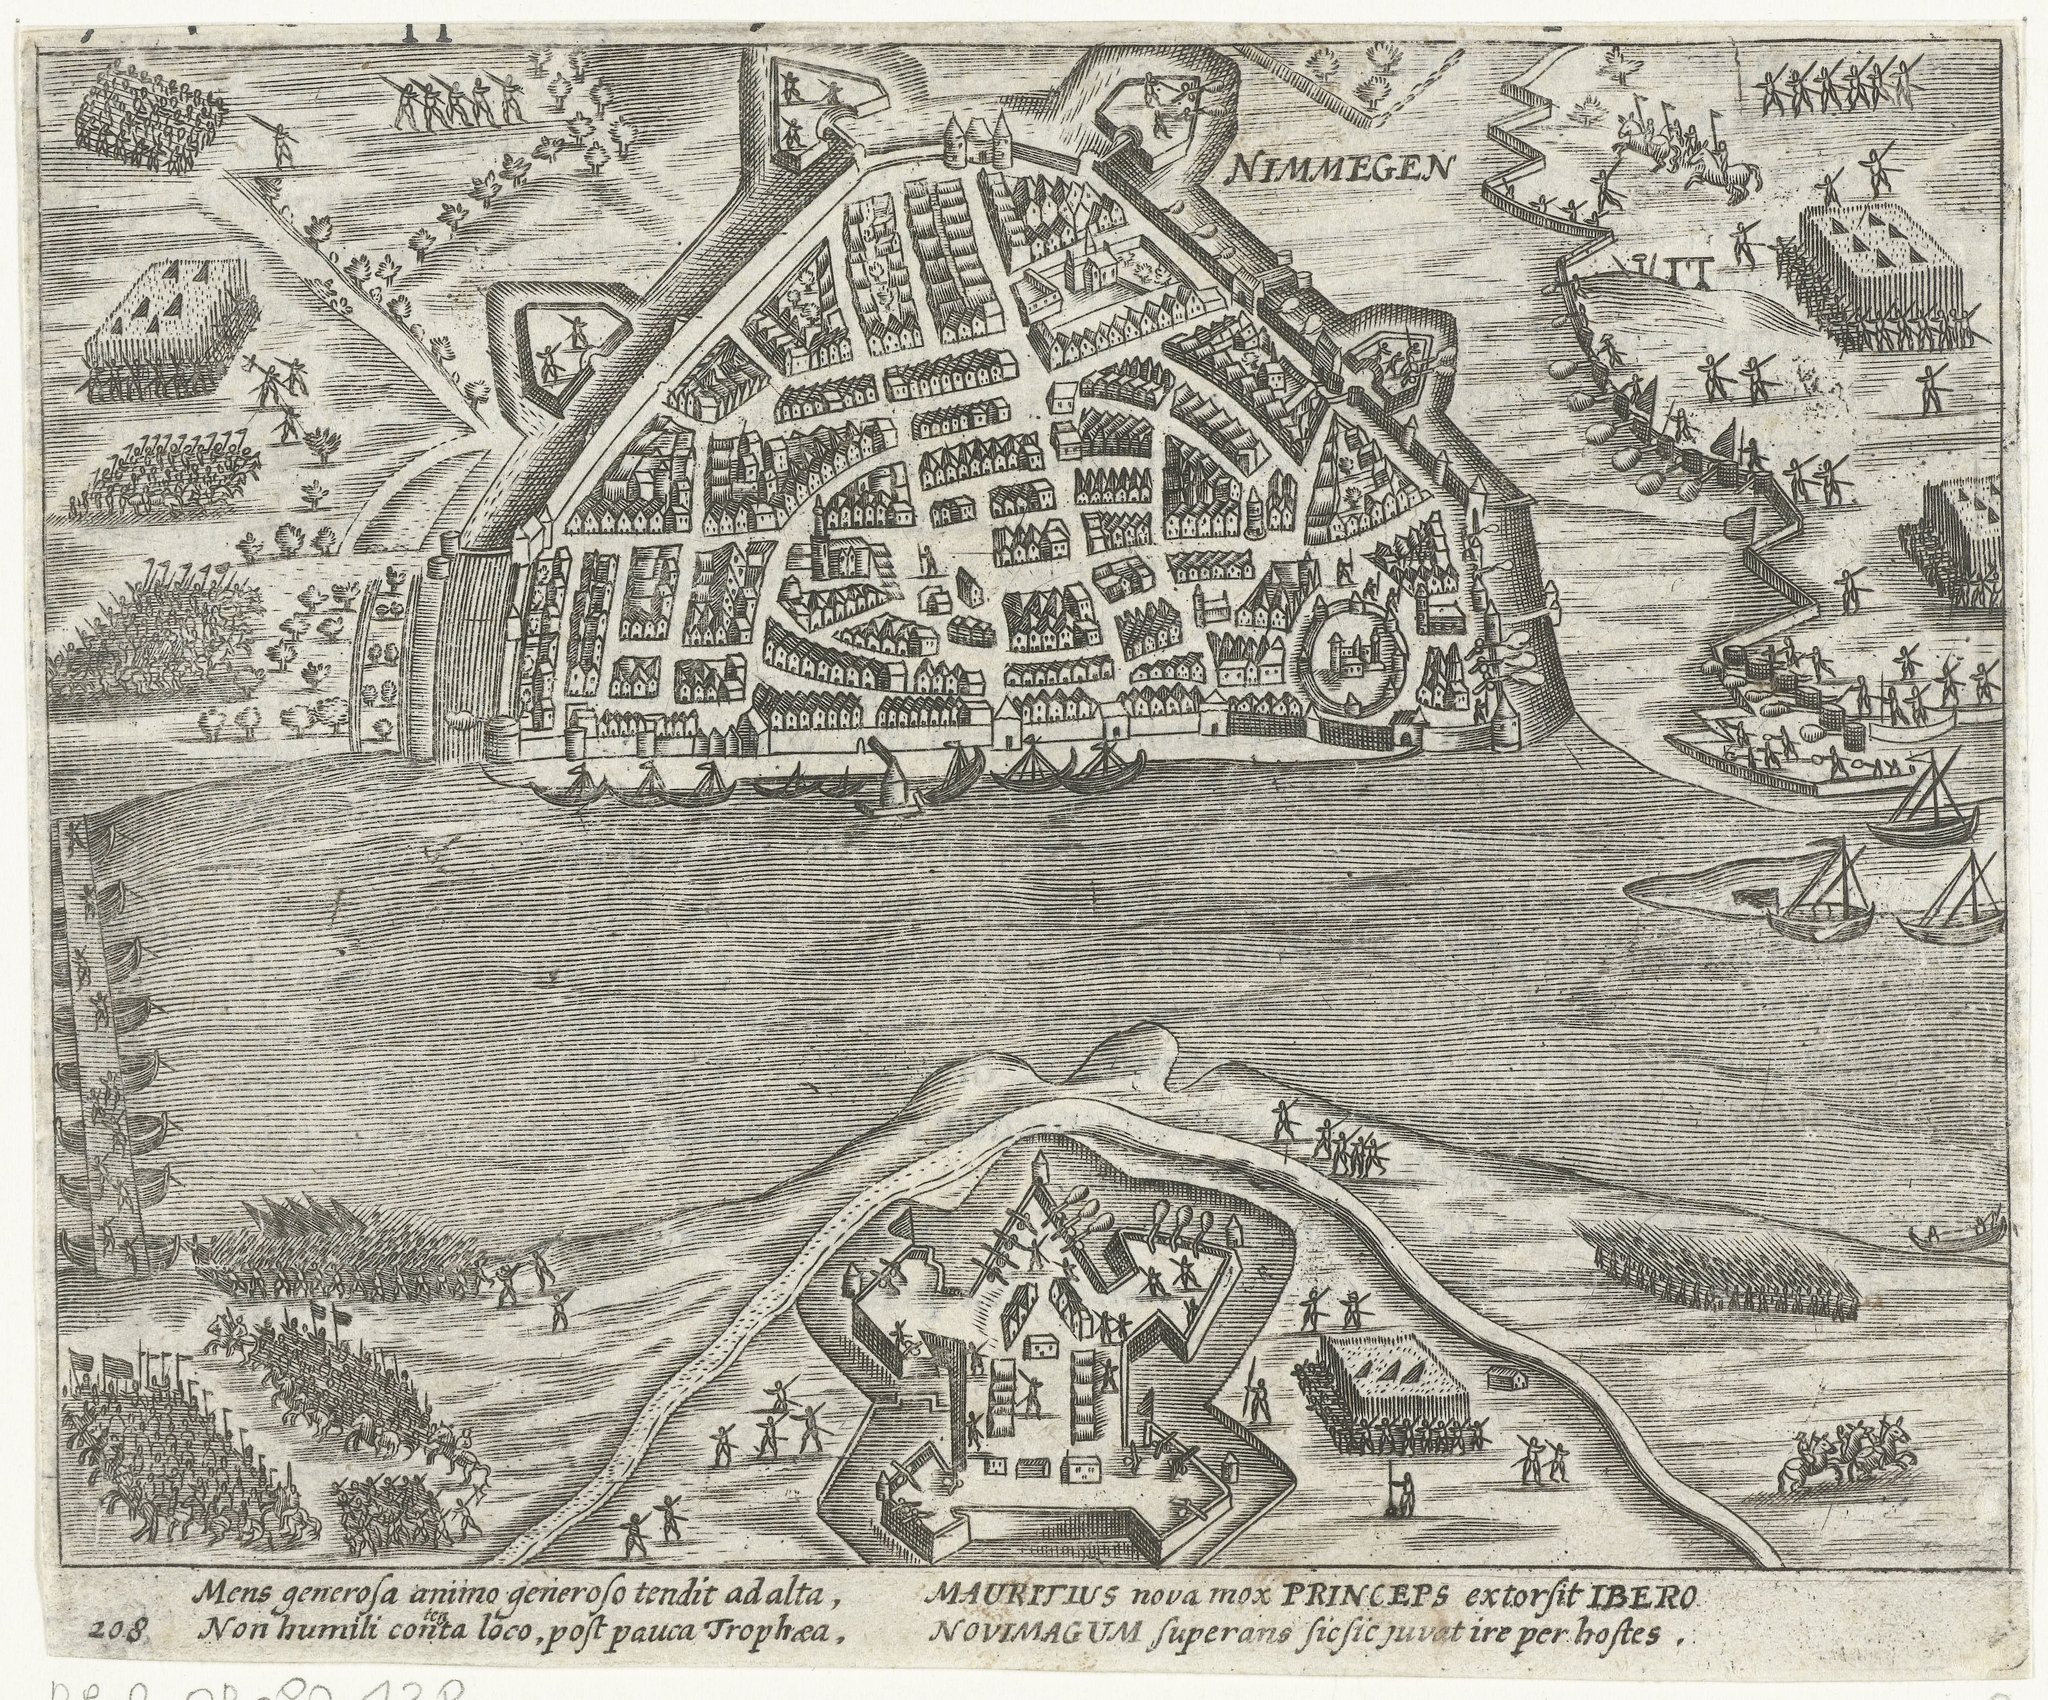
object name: history print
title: Beleg van Nijmegen, 1591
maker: Anonymous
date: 1613-1615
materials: paper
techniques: engraving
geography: northern netherlands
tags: the hague, maurice (prince of orange), siege, position war, nijmegen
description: Beleg van Nijmegen door het Staatse leger onder Maurits, mei 1590 oktober 1591. Plan van Nijmegen met de Waal en het fort Knodsenburg van waaruit Maurits de stad liet beschieten. Met onderschrift van 4 regels in het Latijn. Genummerd 208. Bedrukt op achterzijde met tekst in het Latijn.